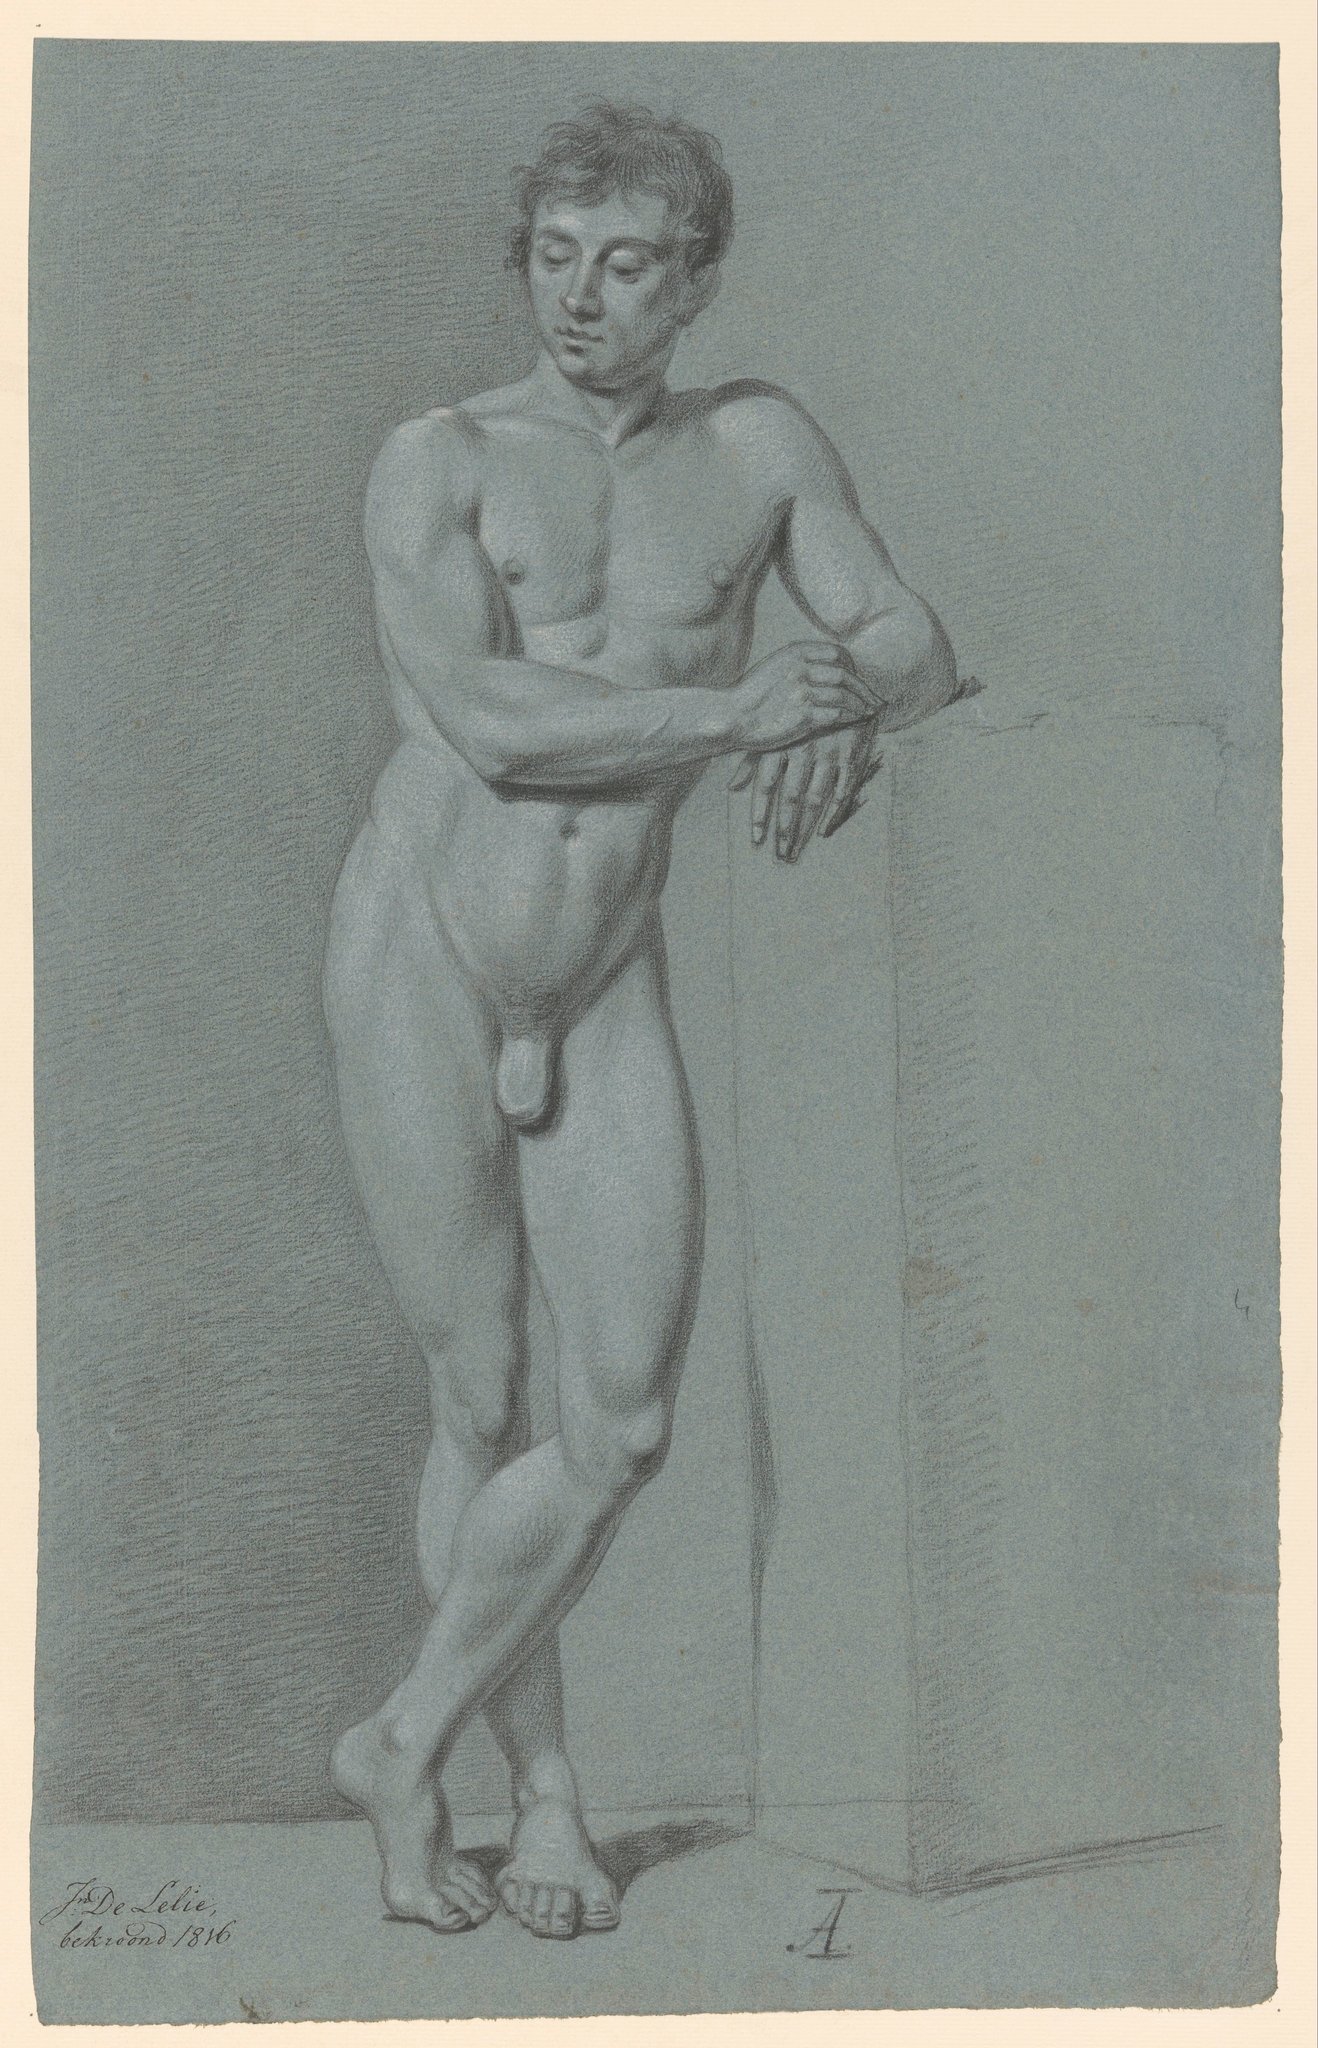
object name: drawing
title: Staand mannelijk naakt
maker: jan adriaan antonie de lelie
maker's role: draughtsman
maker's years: 1788-1845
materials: chalk, paper